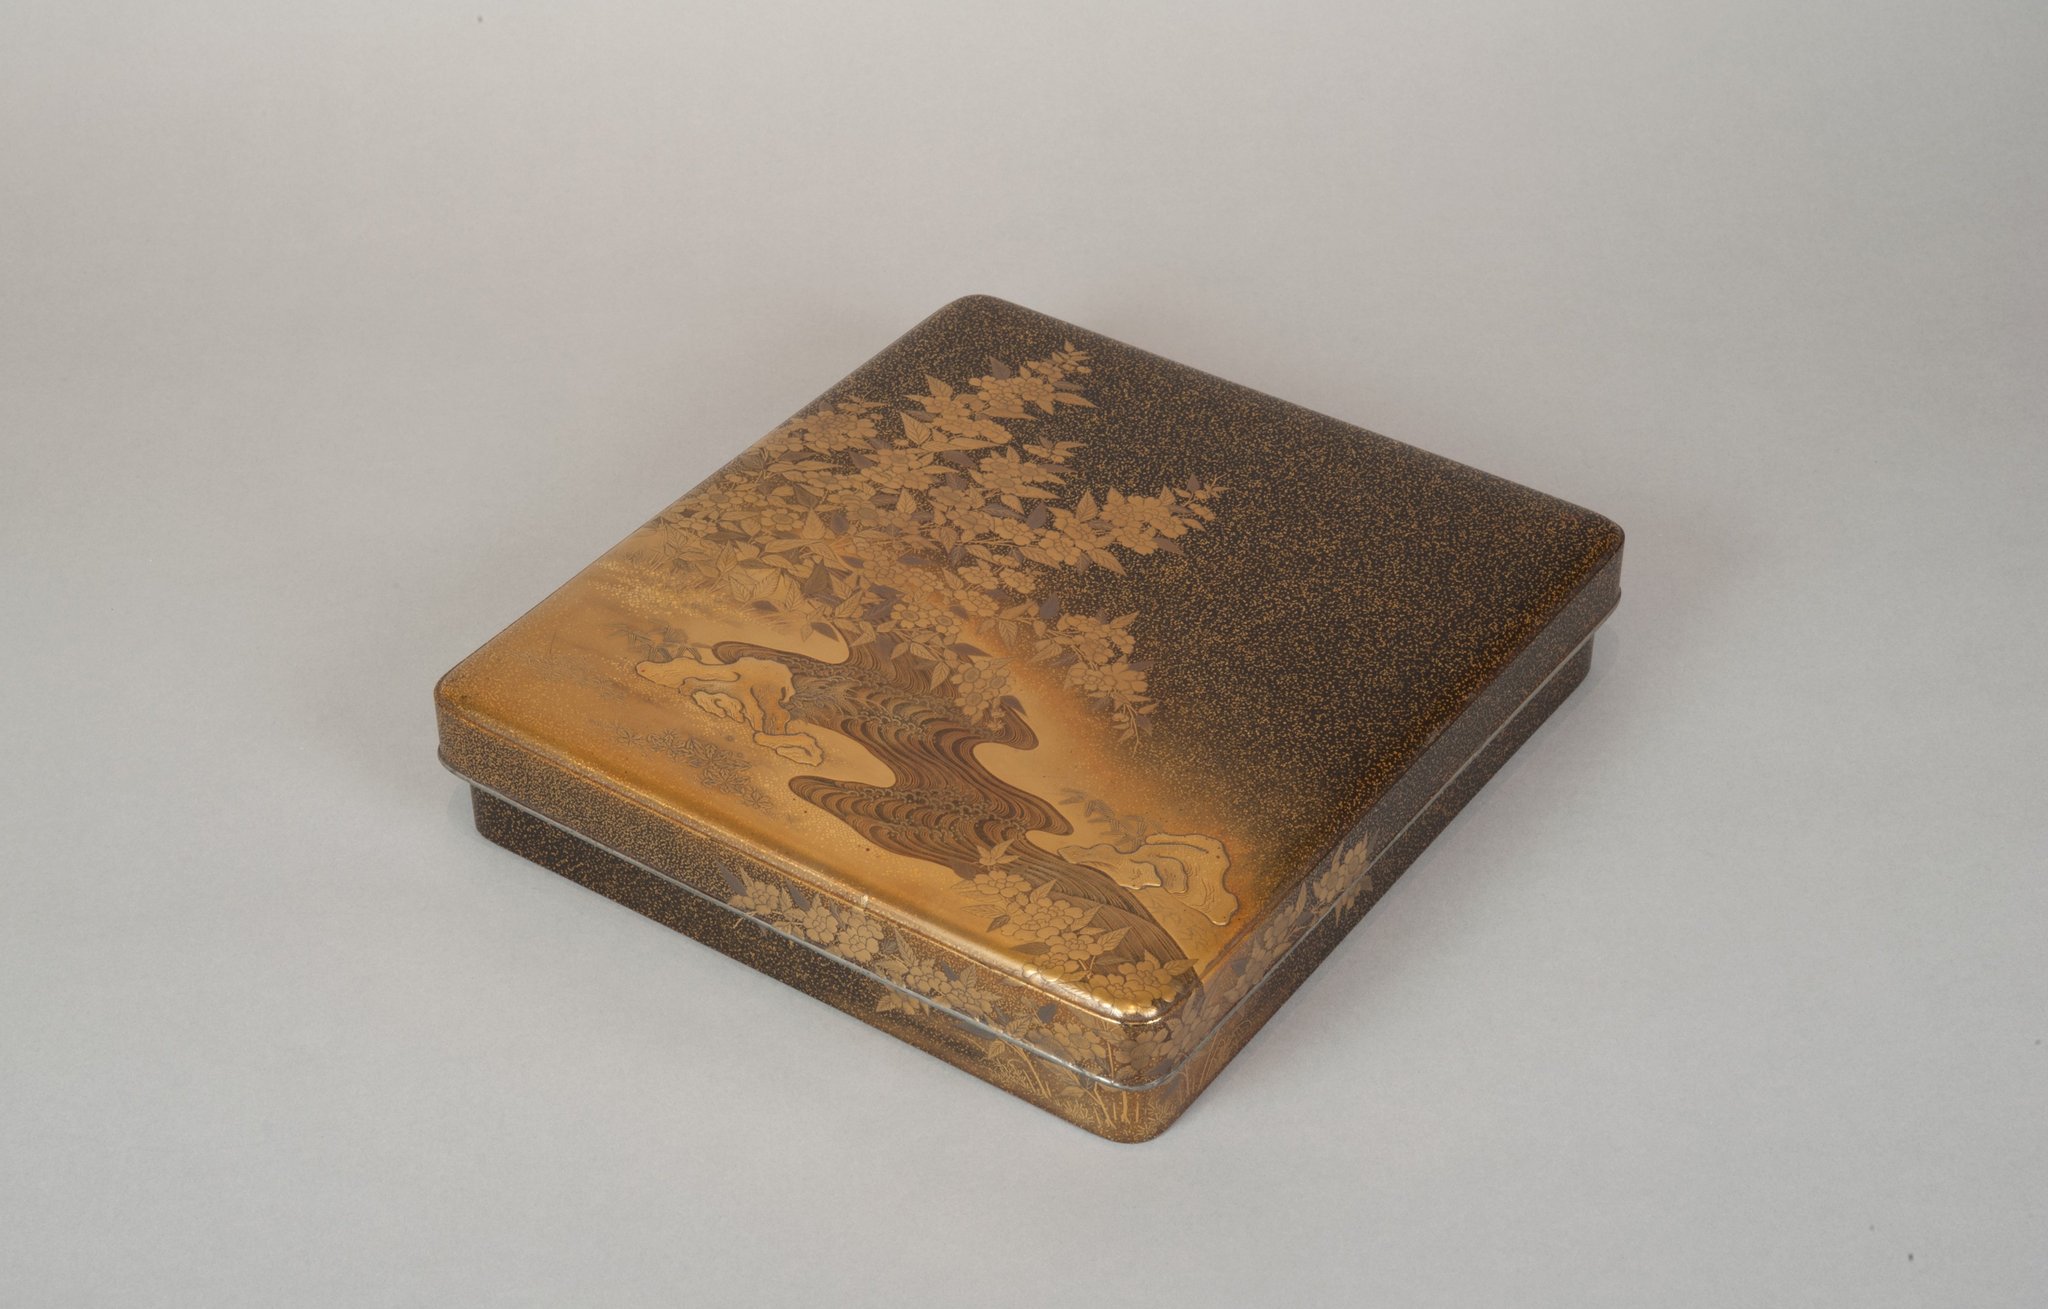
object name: writingn box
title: Writing Box with Yellow Rose Flowers and Rushing Stream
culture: japanese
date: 1701-1800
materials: gold, gold foil, lacquer, silver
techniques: hiramakie, maki-e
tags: flowers,streams